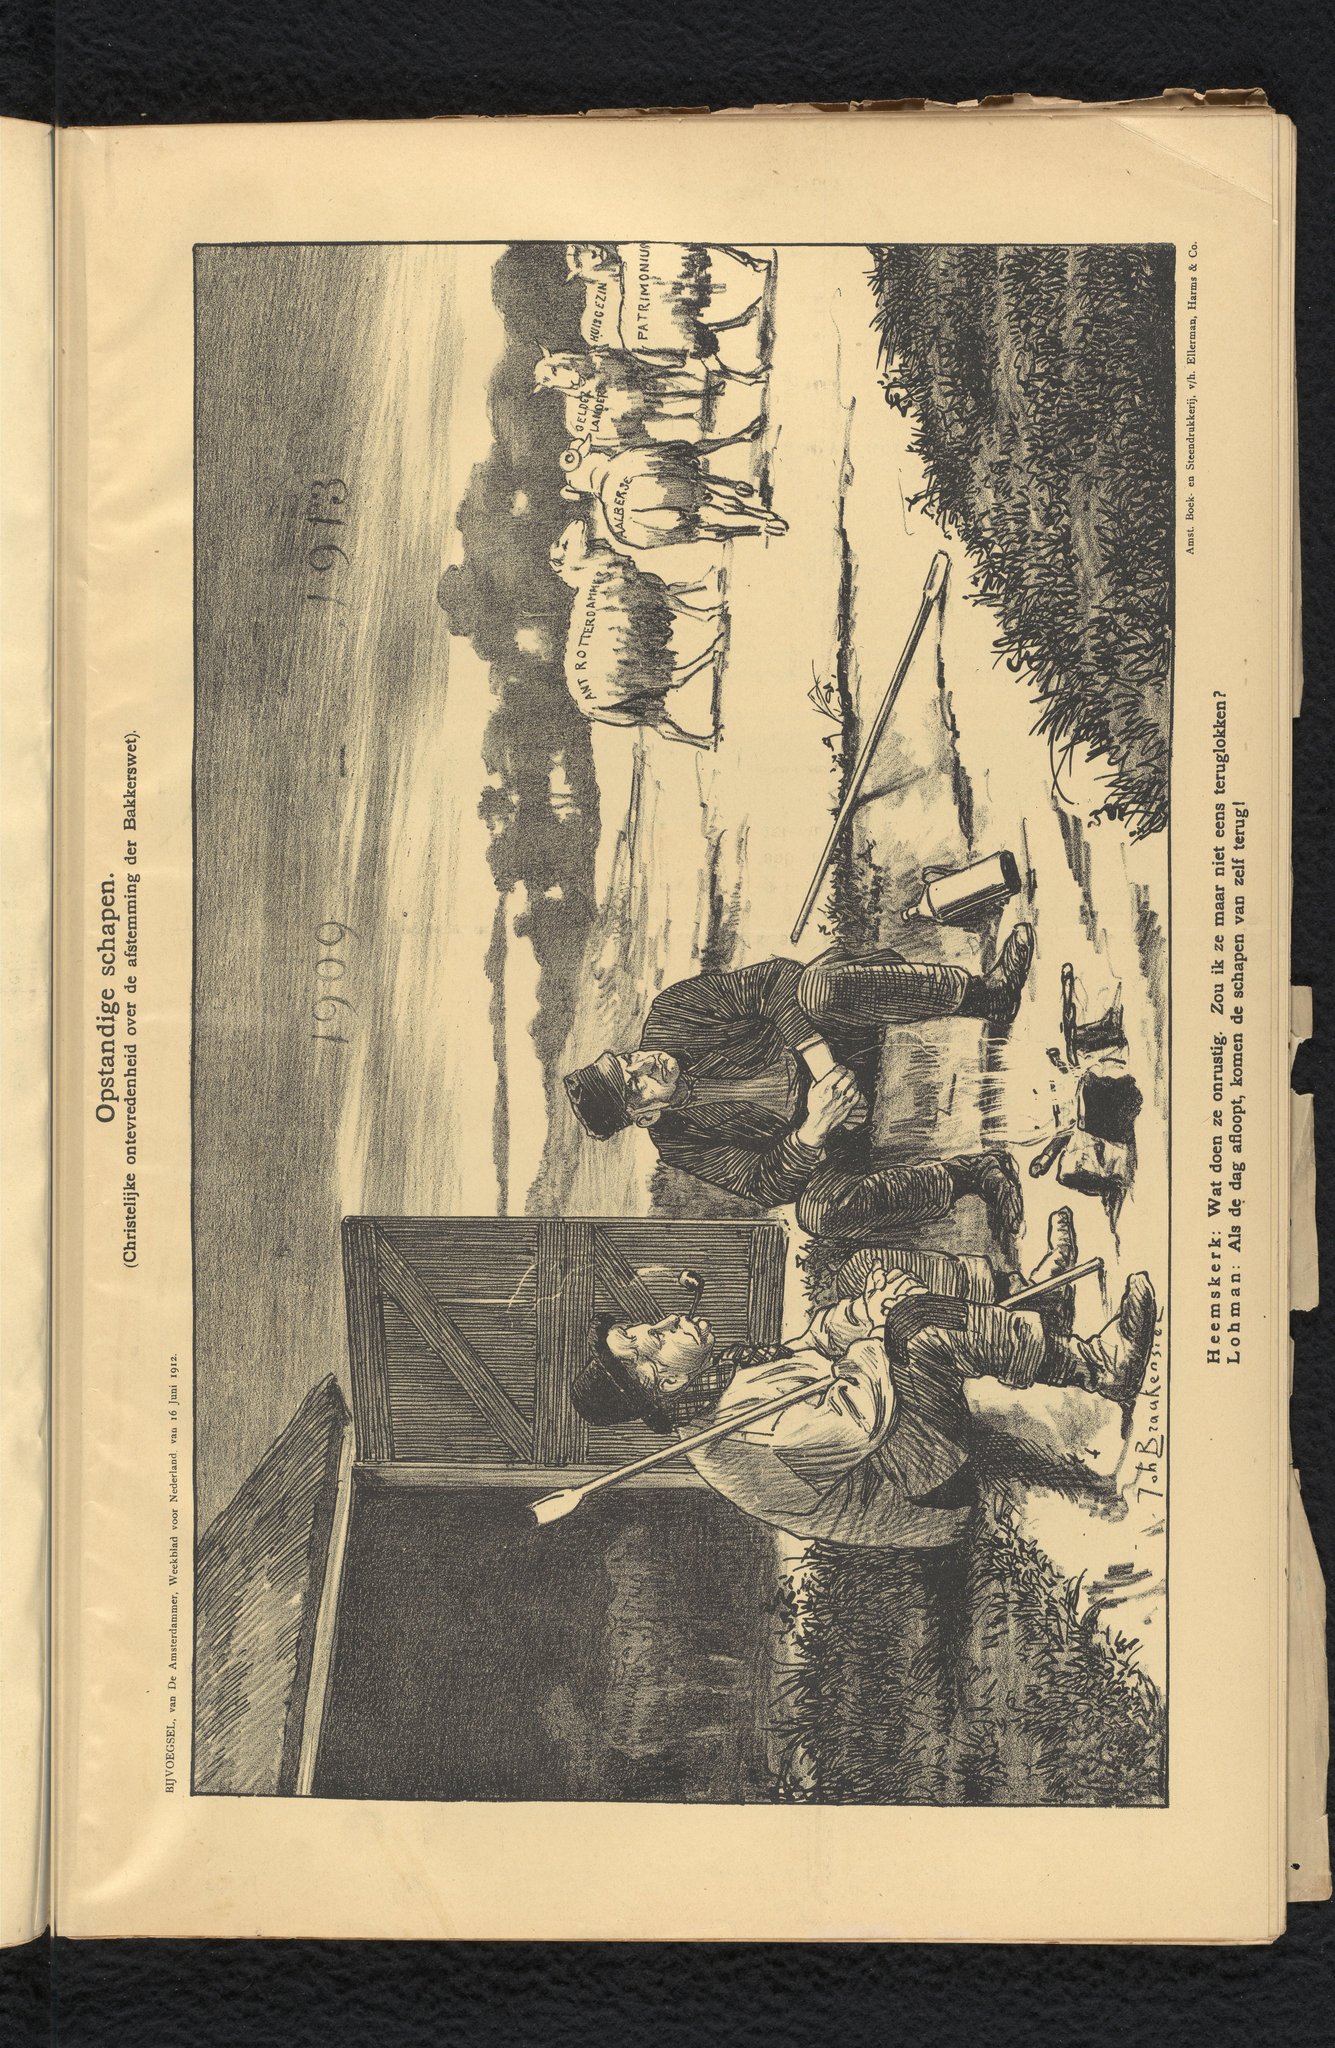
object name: cartoon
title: Opstandige schapen. (Christelijke ontevredenheid over de afstemming der Bakkerswet)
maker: johan braakensiek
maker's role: draughtsman, print maker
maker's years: 1858-1940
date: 1912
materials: paper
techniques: lithograph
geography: amsterdam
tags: the hague, jonkheer alexander frederik de savornin lohman, amsterdam, utrecht, herding, herdsman, herdswoman, shepherd, shepherdess, cowherd, etc., political caricatures and satires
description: Premier Heemskerk en kamerlid De Savornin Lohman als herders die, gezeten bij een kampvuur, een deel van hun kudde schapen ziet weglopen. In de lucht de jaren 1909-1913.